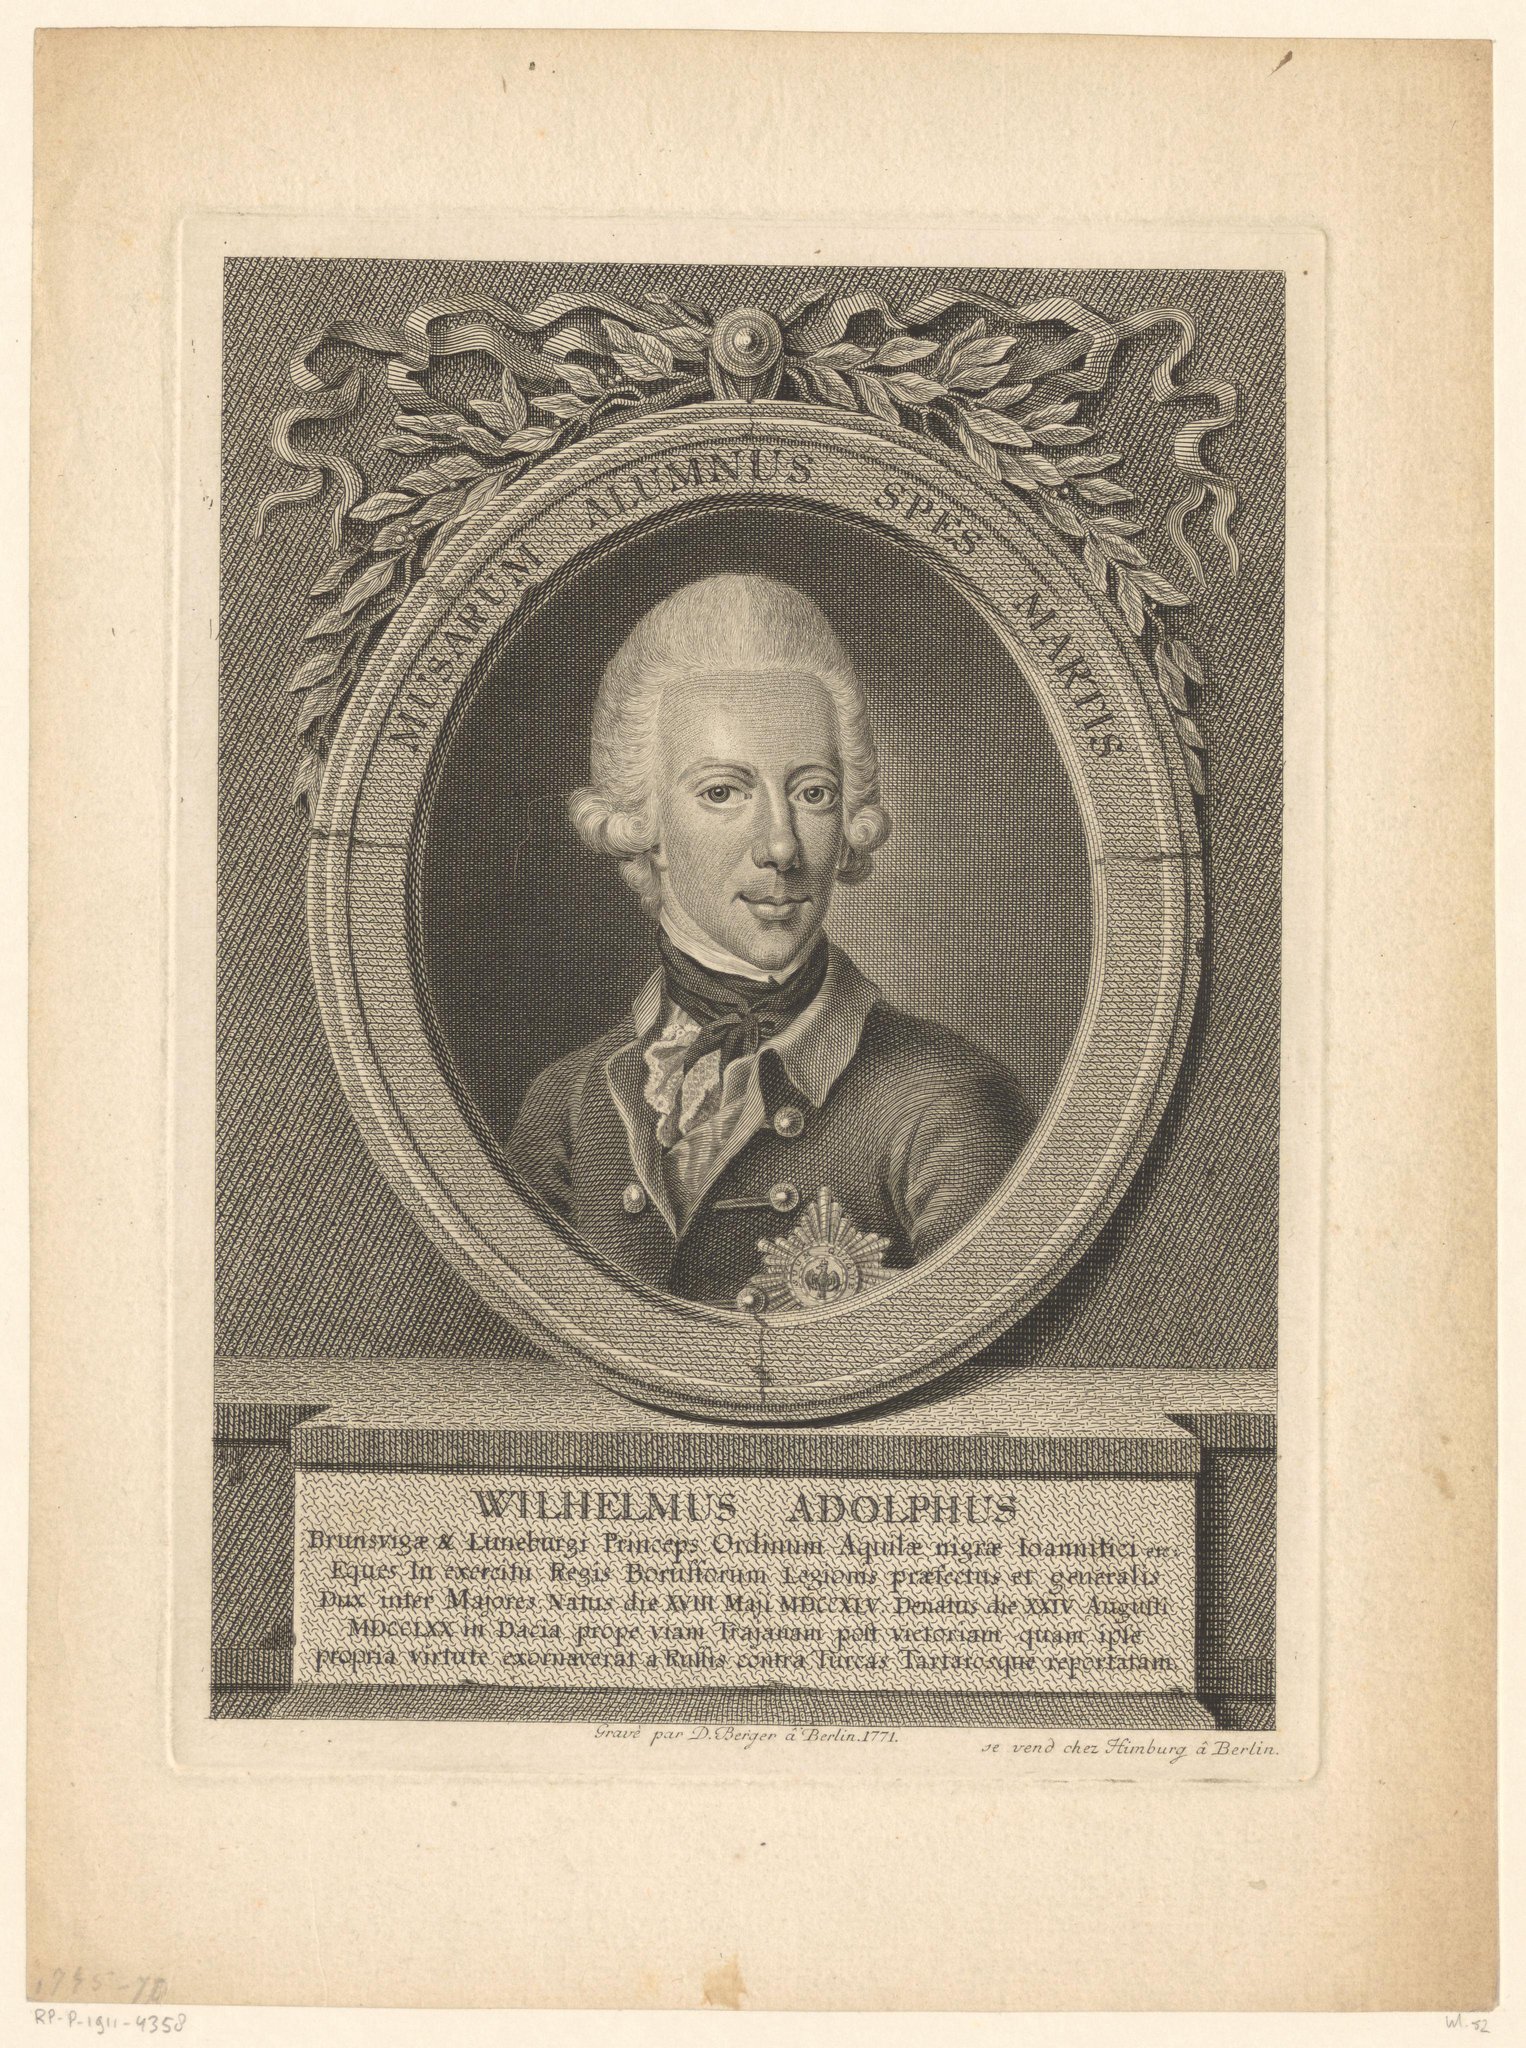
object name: print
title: Portret van Wilhelm Adolph von Braunschweig-Wolfenbüttel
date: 1771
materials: paper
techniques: engraving, etching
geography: berlin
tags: historical persons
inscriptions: collector's mark: Lugt 2228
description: Prent ook gebruikt in: Entwurf von dem Caracter und den fürnehmsten Lebens-Umständen des höchstseelingen Prinzen Wilhelm Adolph von Braunschweig und Lüneburg. Berlijn: Christian Friedrich Himburg, 1771.